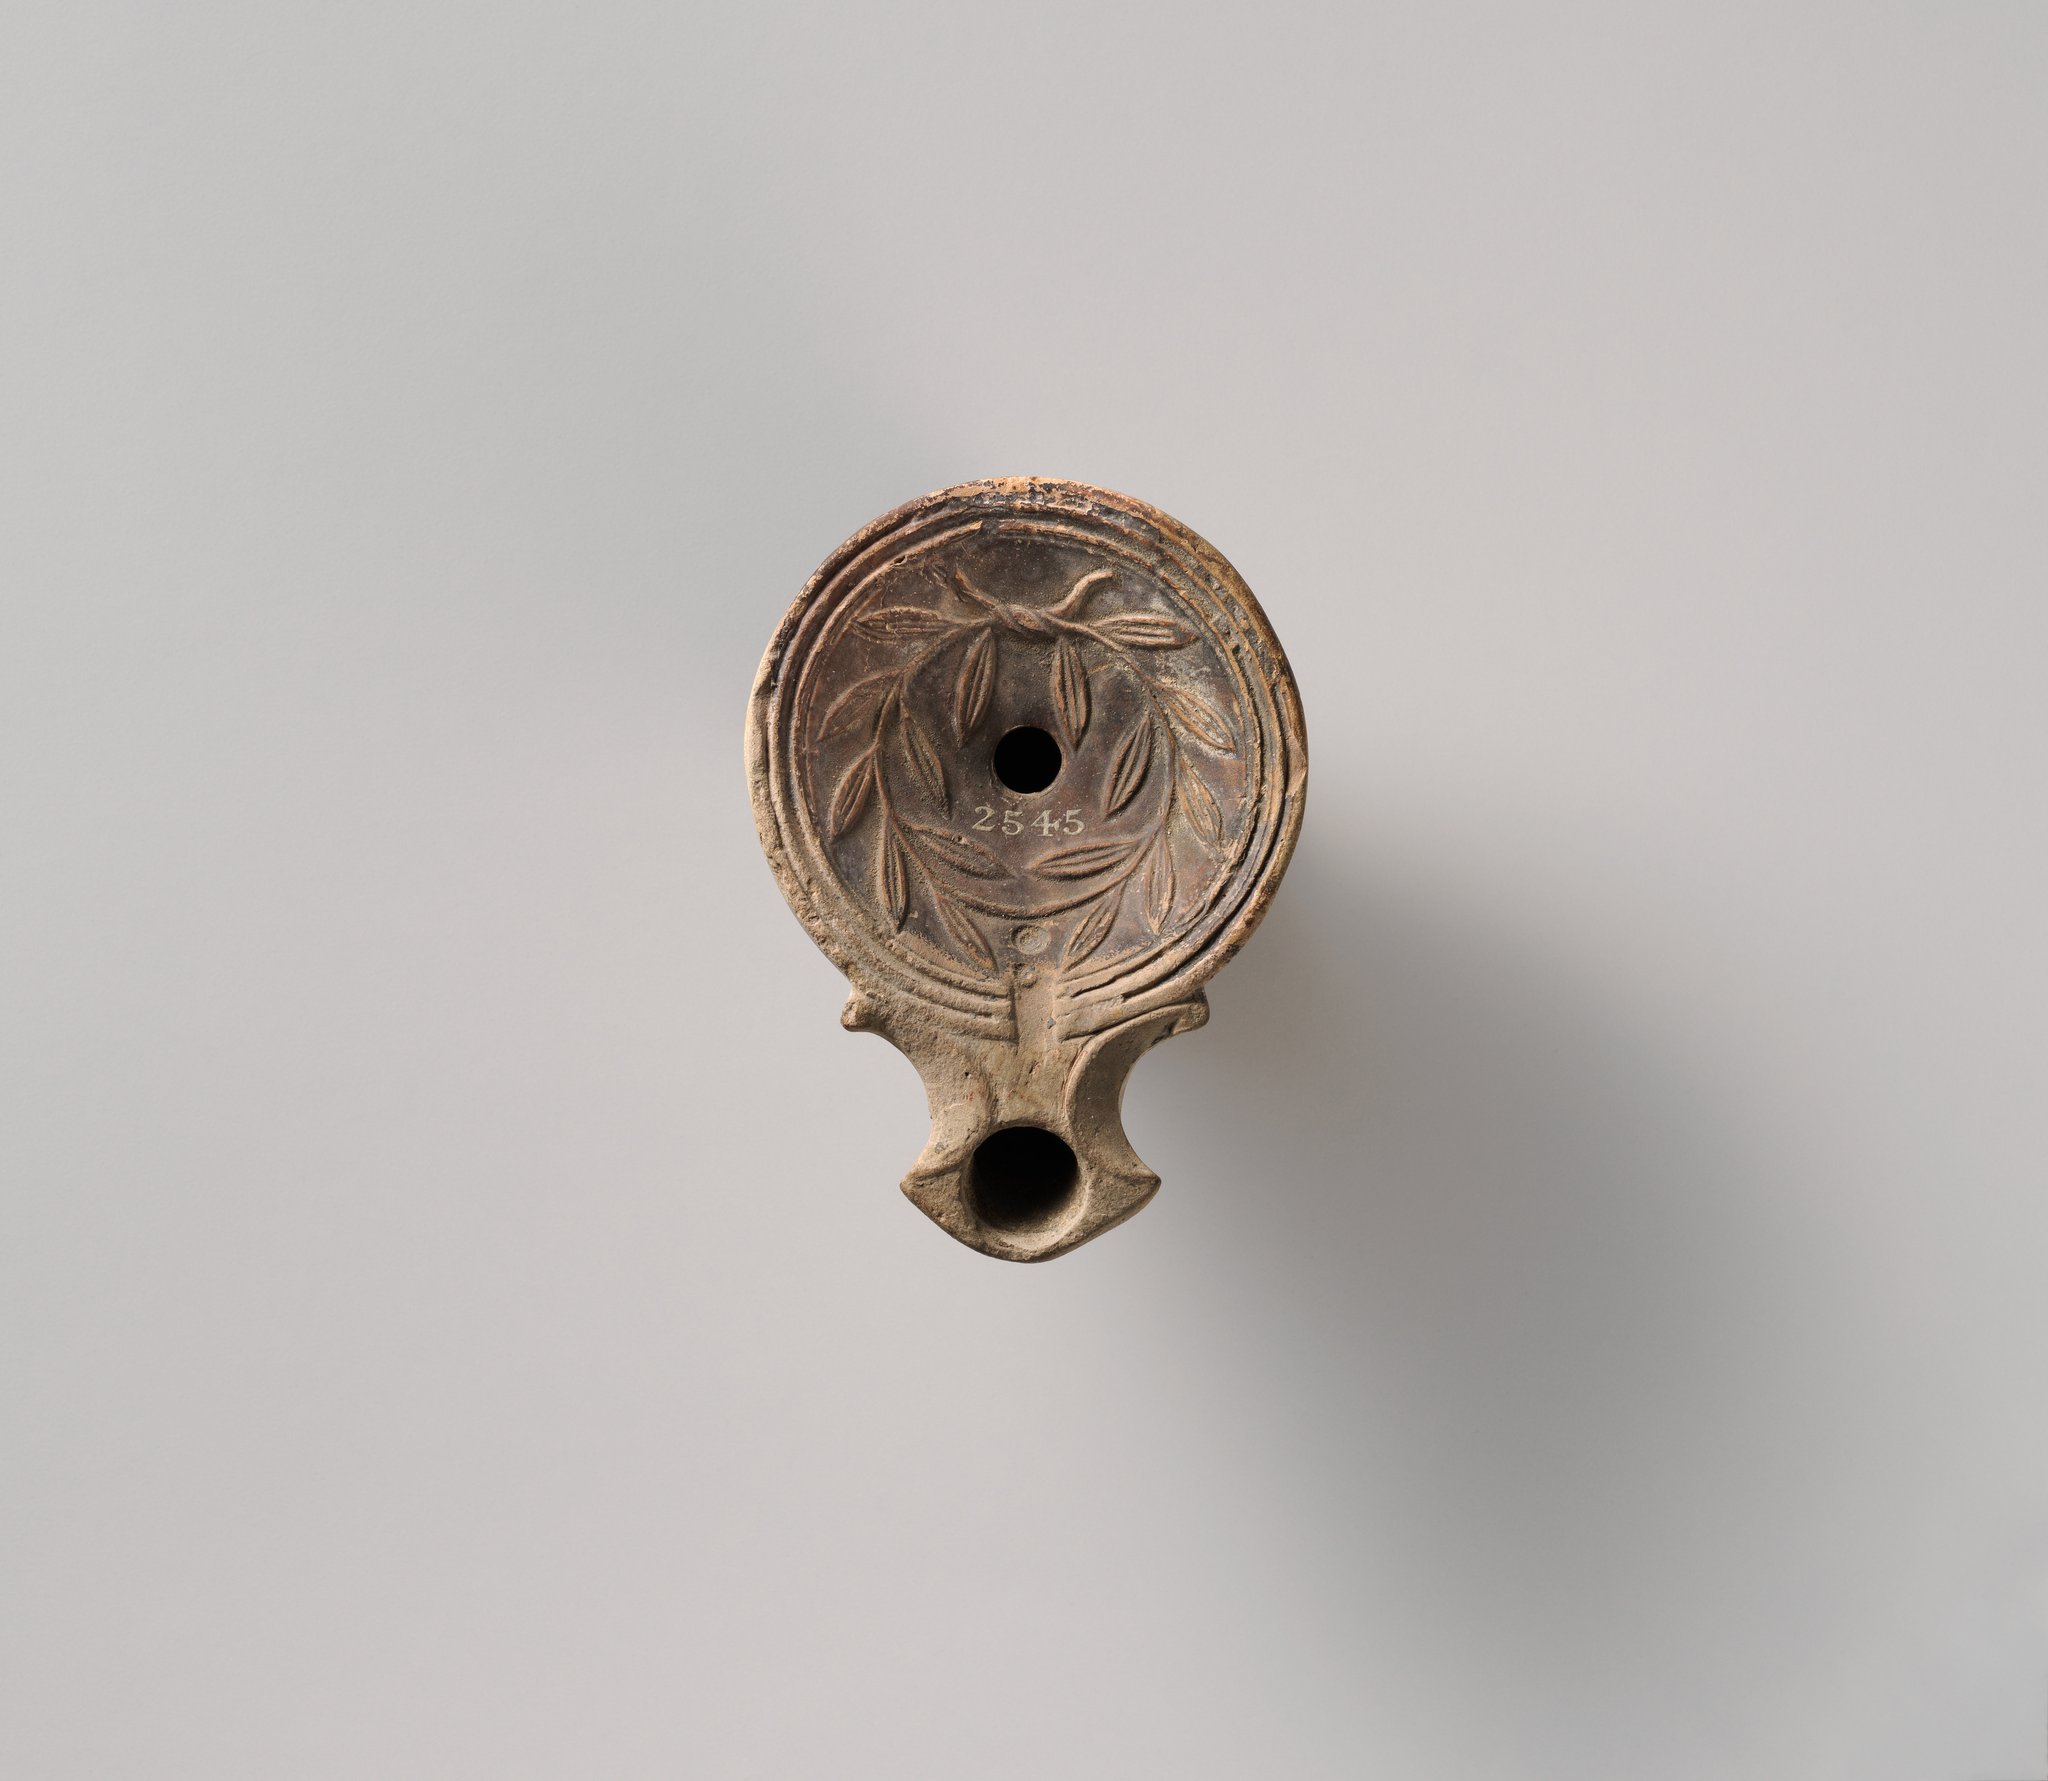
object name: lamp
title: Terracotta oil lamp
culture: roman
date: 100 BCE-100 CE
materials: terracotta